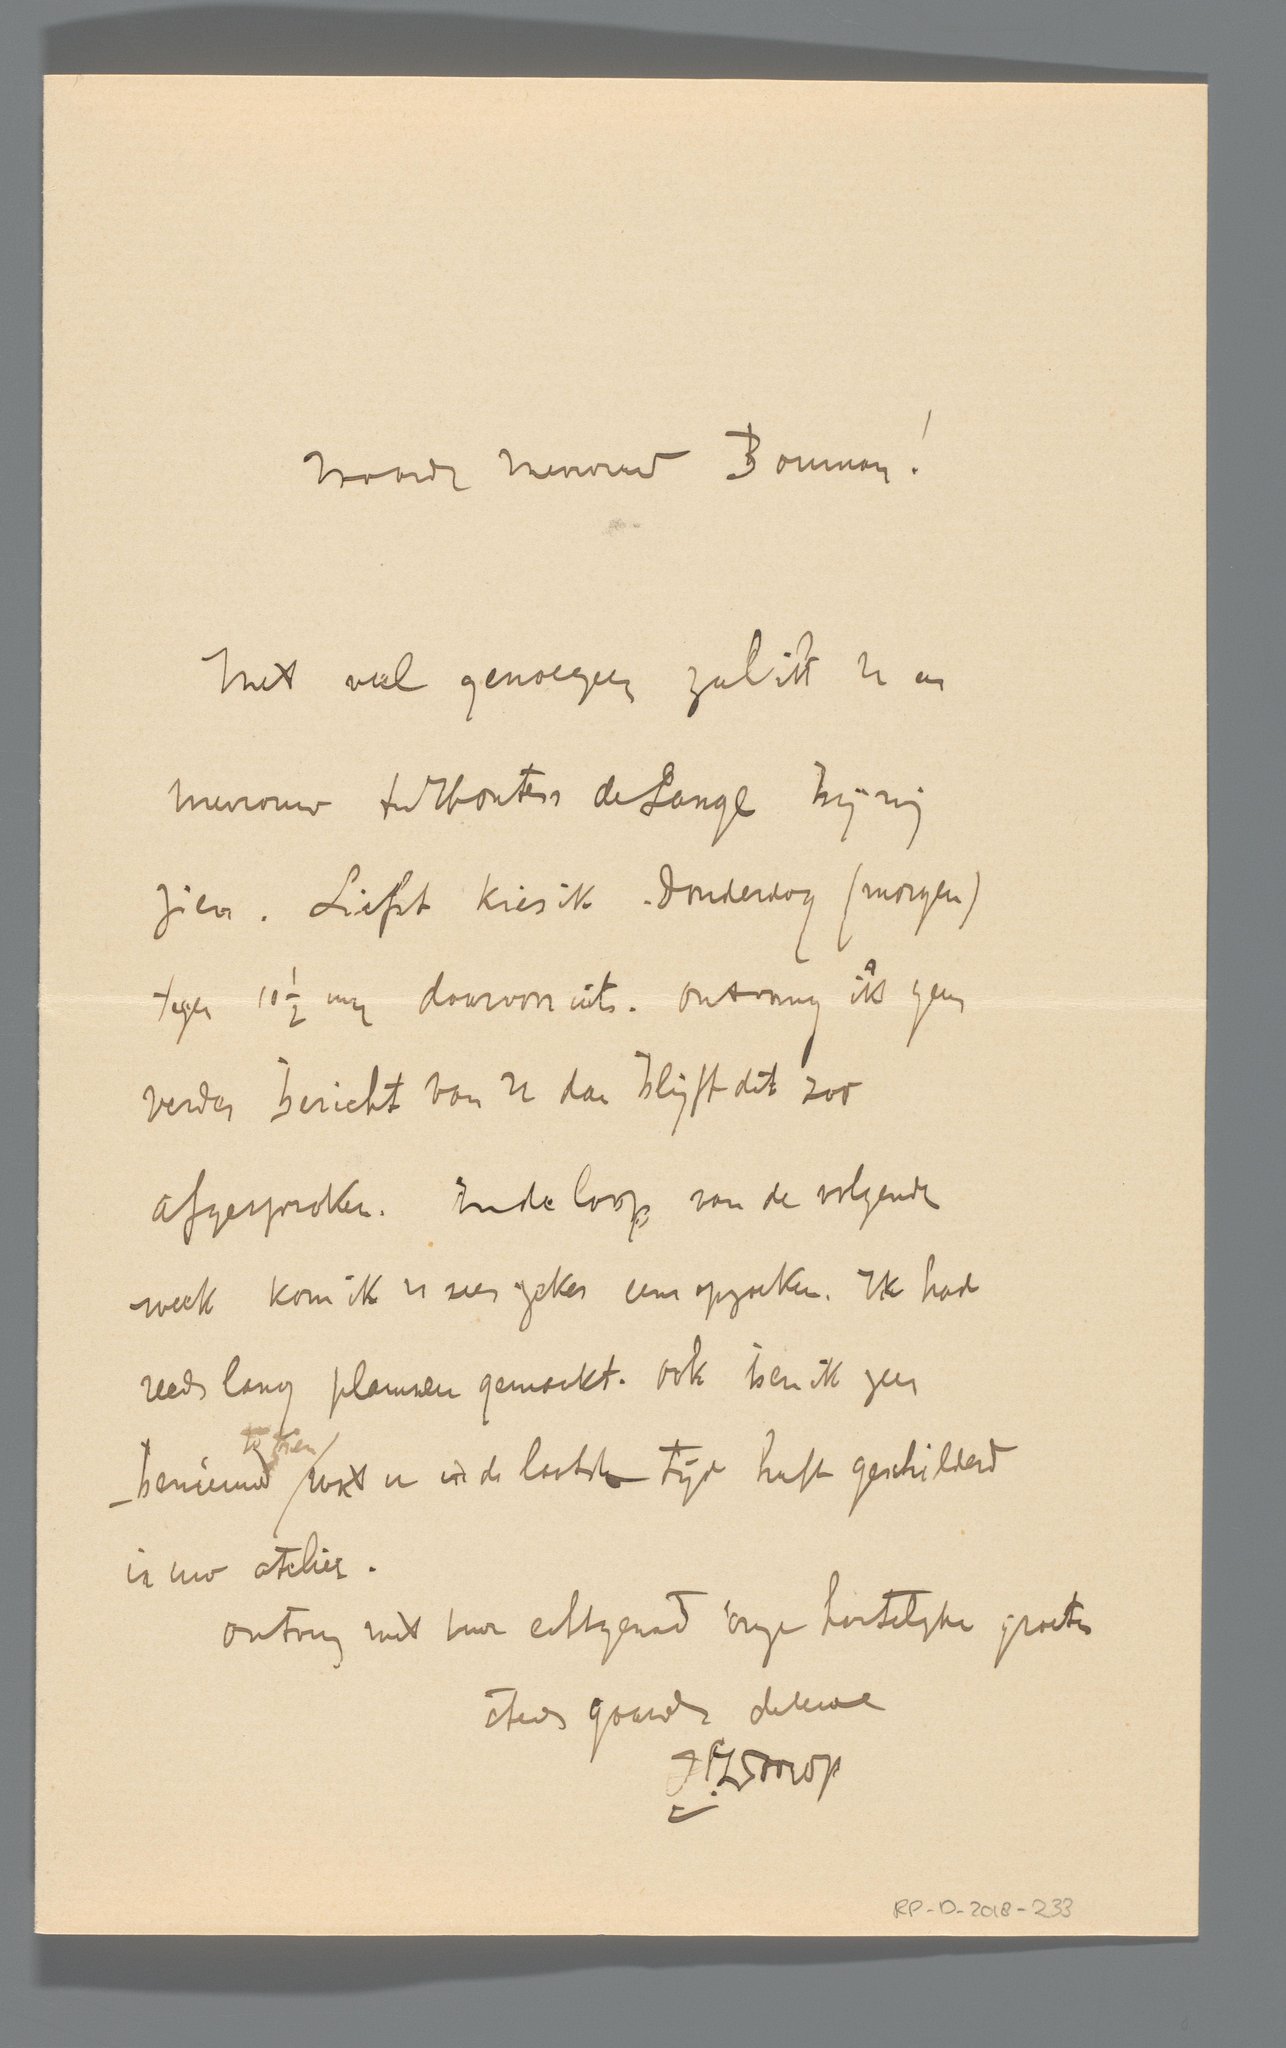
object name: letter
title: Brief aan Jeannette Bouman-Stuyling de Lange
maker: jan toorop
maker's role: draughtsman, painter, print maker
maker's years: 1858-1928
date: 1899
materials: ink, paper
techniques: pen, writing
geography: the hague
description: Brief gericht aan Mevrouw M.J. Bouman, Geb de Lange, Villa Vineta, van Stolkpark, Scheveningen.